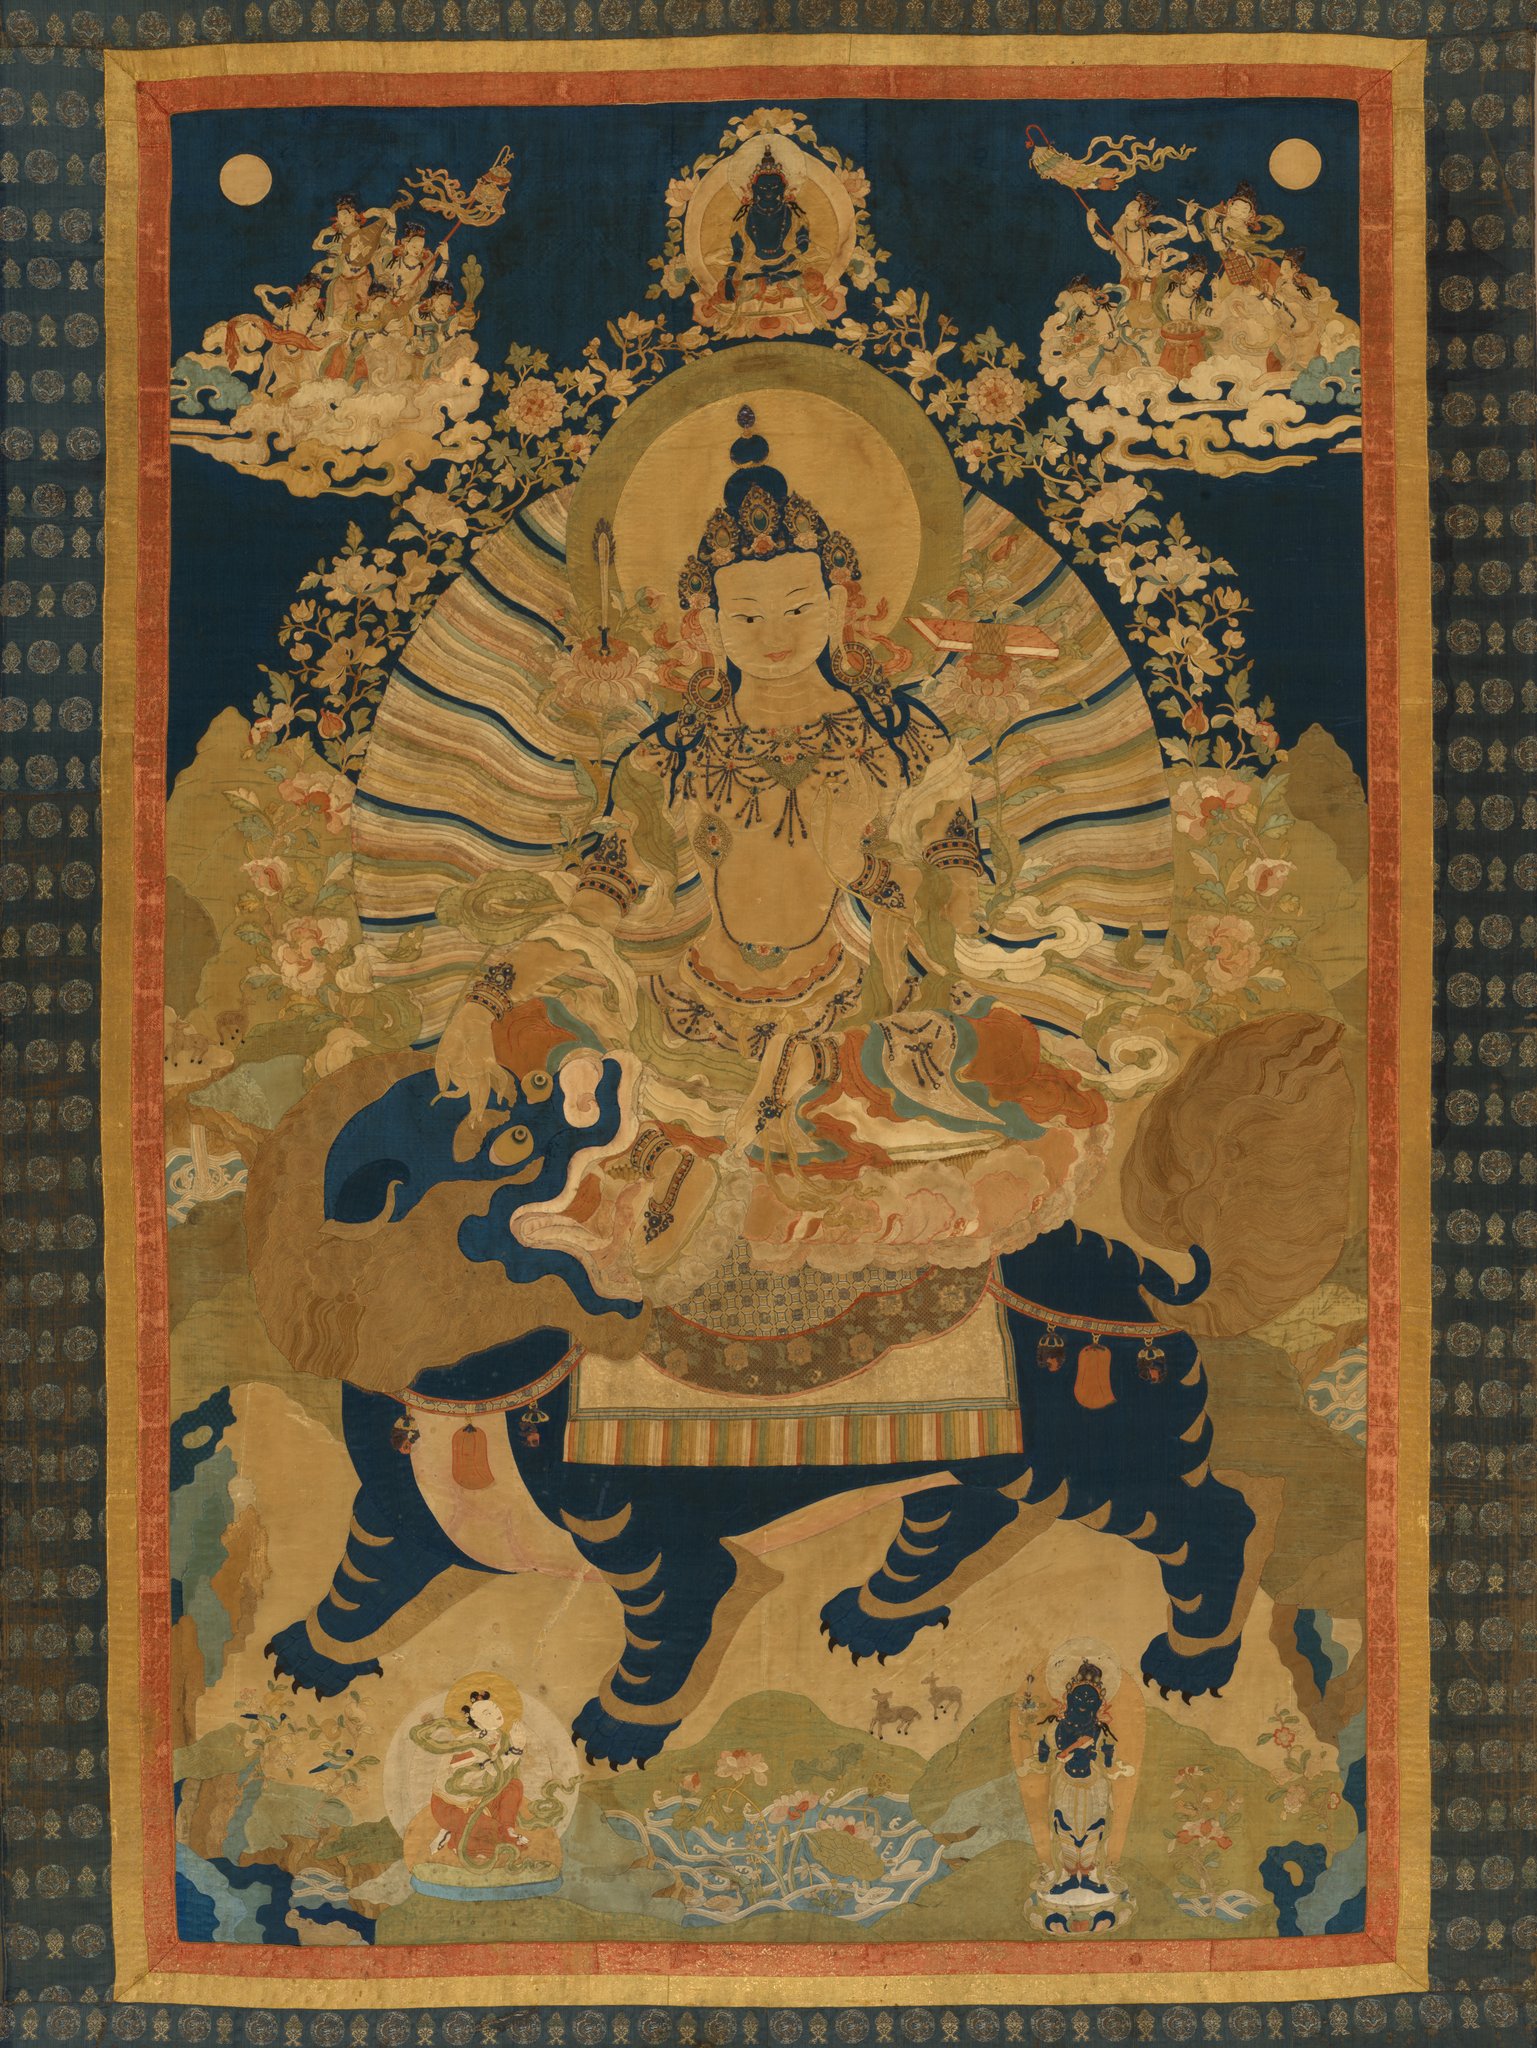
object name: hanging, temple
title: Manjushri, the Bodhisattva of Transcendent Wisdom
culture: chinese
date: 1601-1800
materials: cord, leather, textile, silk, silver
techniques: appliqué, brocade, damask, embroidery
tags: deer,bodhisattvas,manjushri